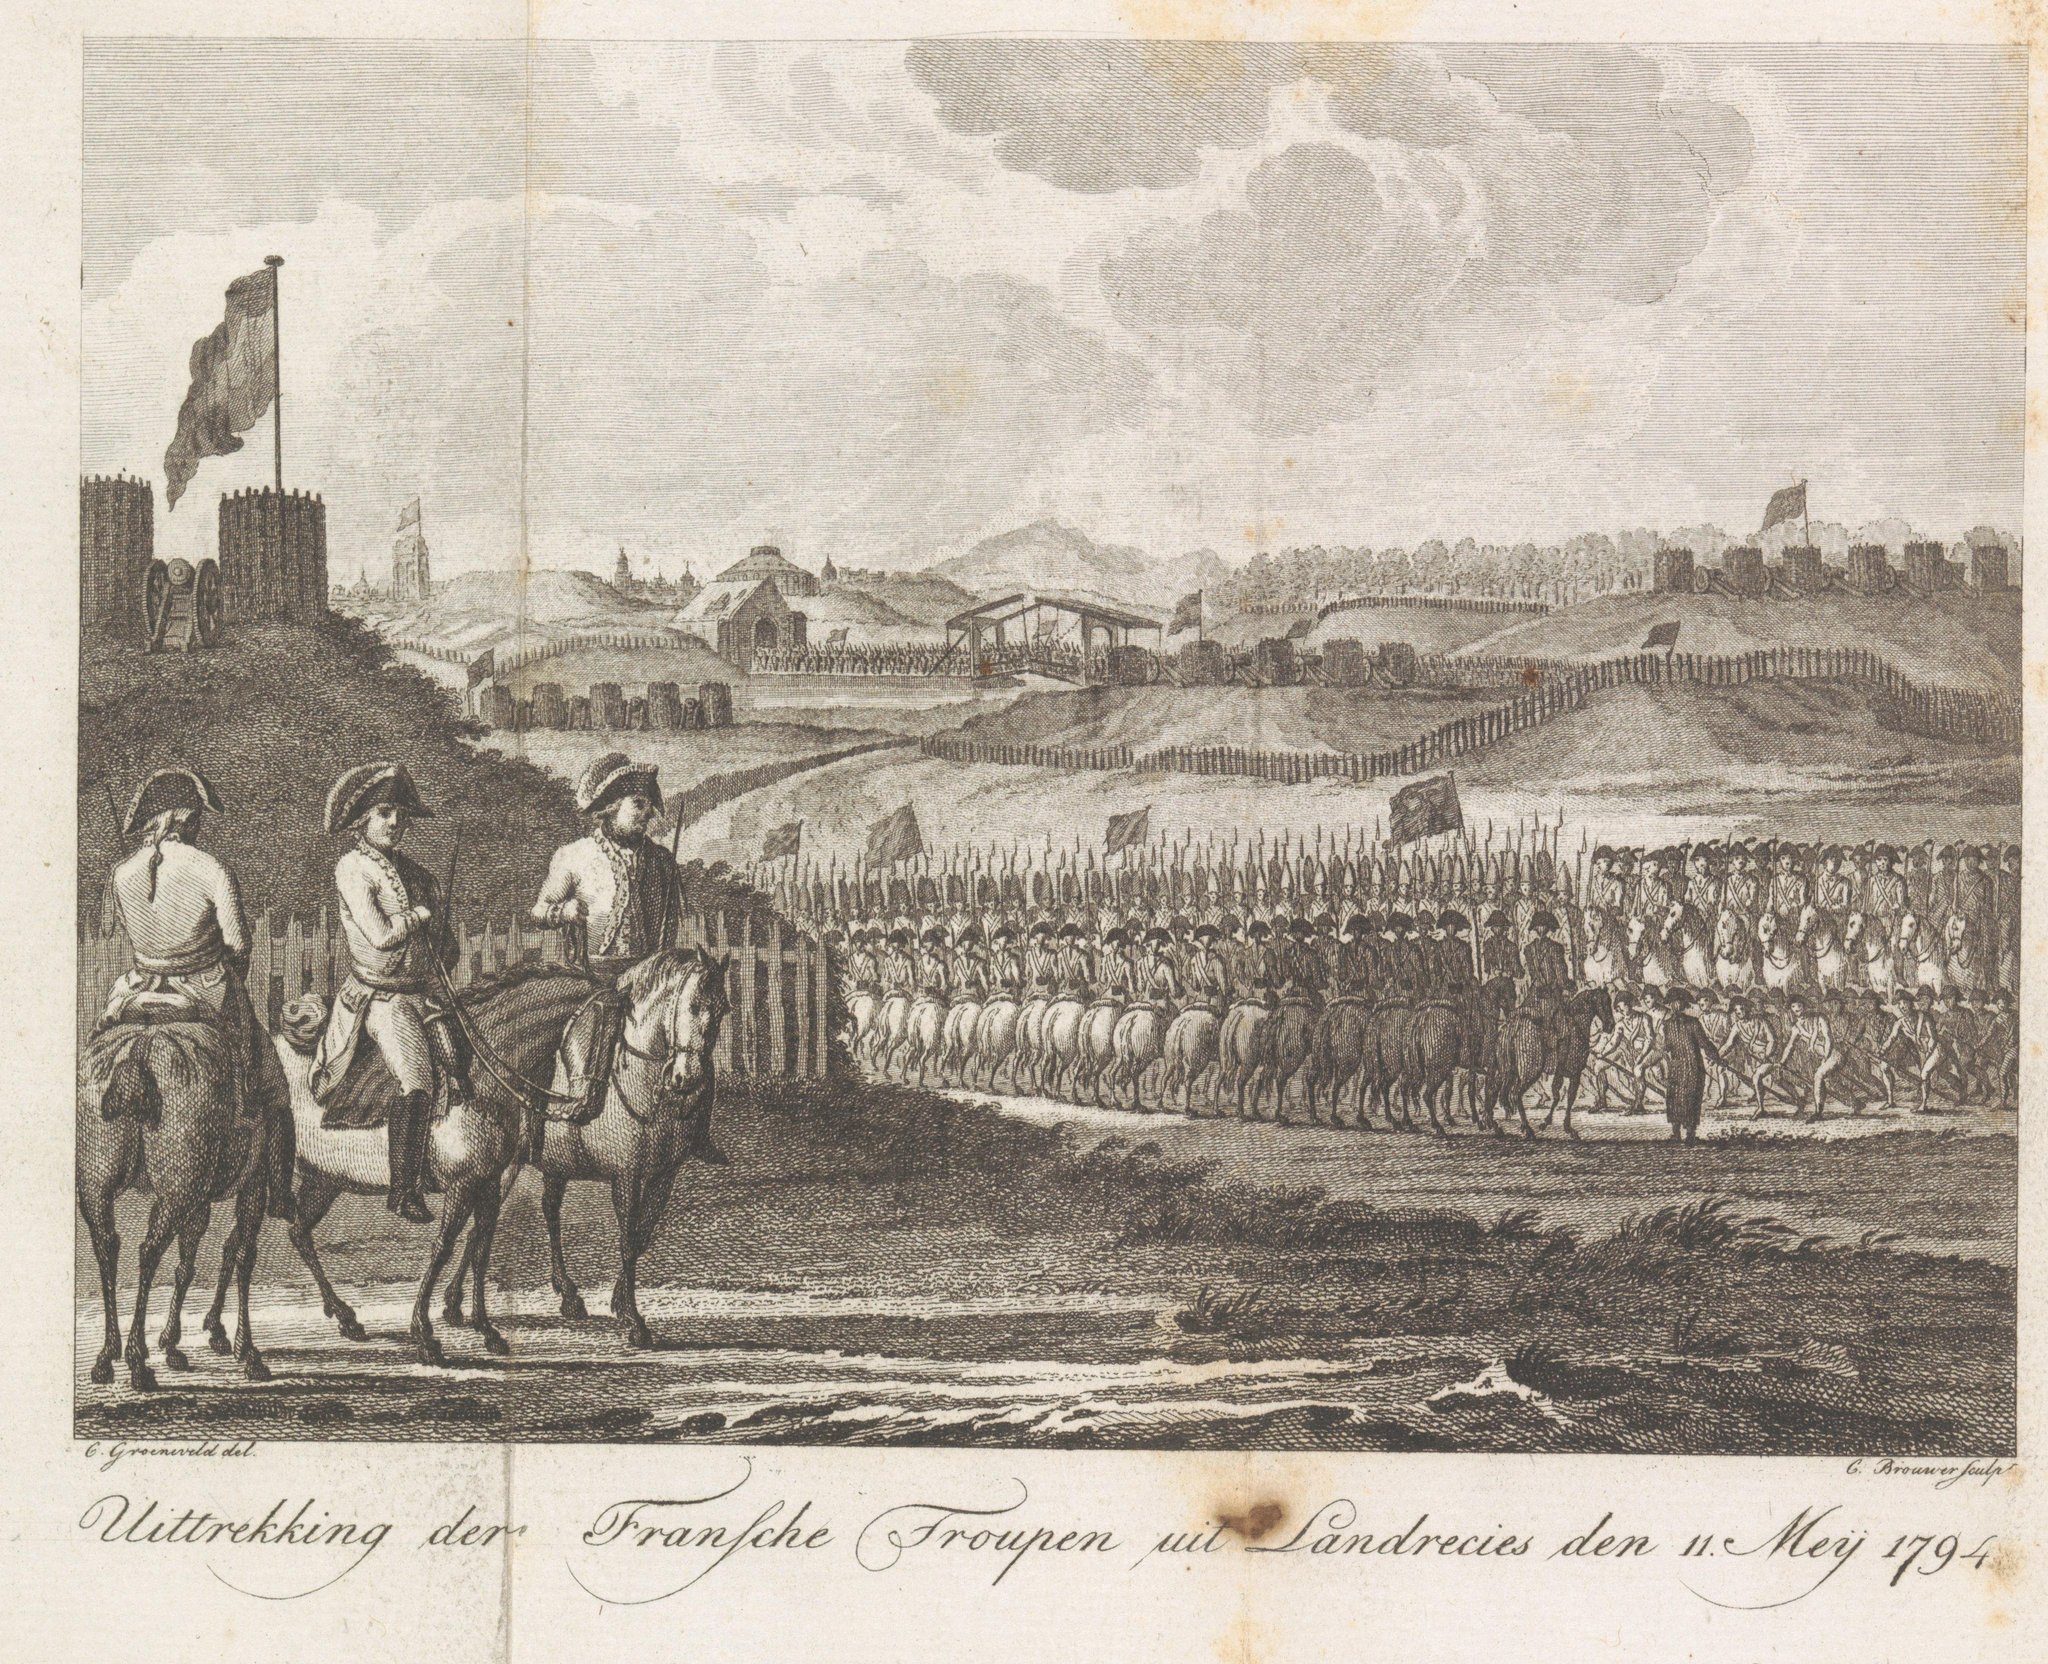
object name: book illustration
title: Franse troepen verlaten Landrecy, 1794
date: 1803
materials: paper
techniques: engraving, etching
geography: netherlands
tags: willem george frederik (prins van oranje-nassau), retreat of the defeated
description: De Franse troepen trekken weg uit Landrecy na de overgave van de stad op 11 mei 1794. Op de voorgrond zien Oostenrijkse troepen toe. Illustratie in het vierdelige Leven van Willem George Fredrik (1802-1803).